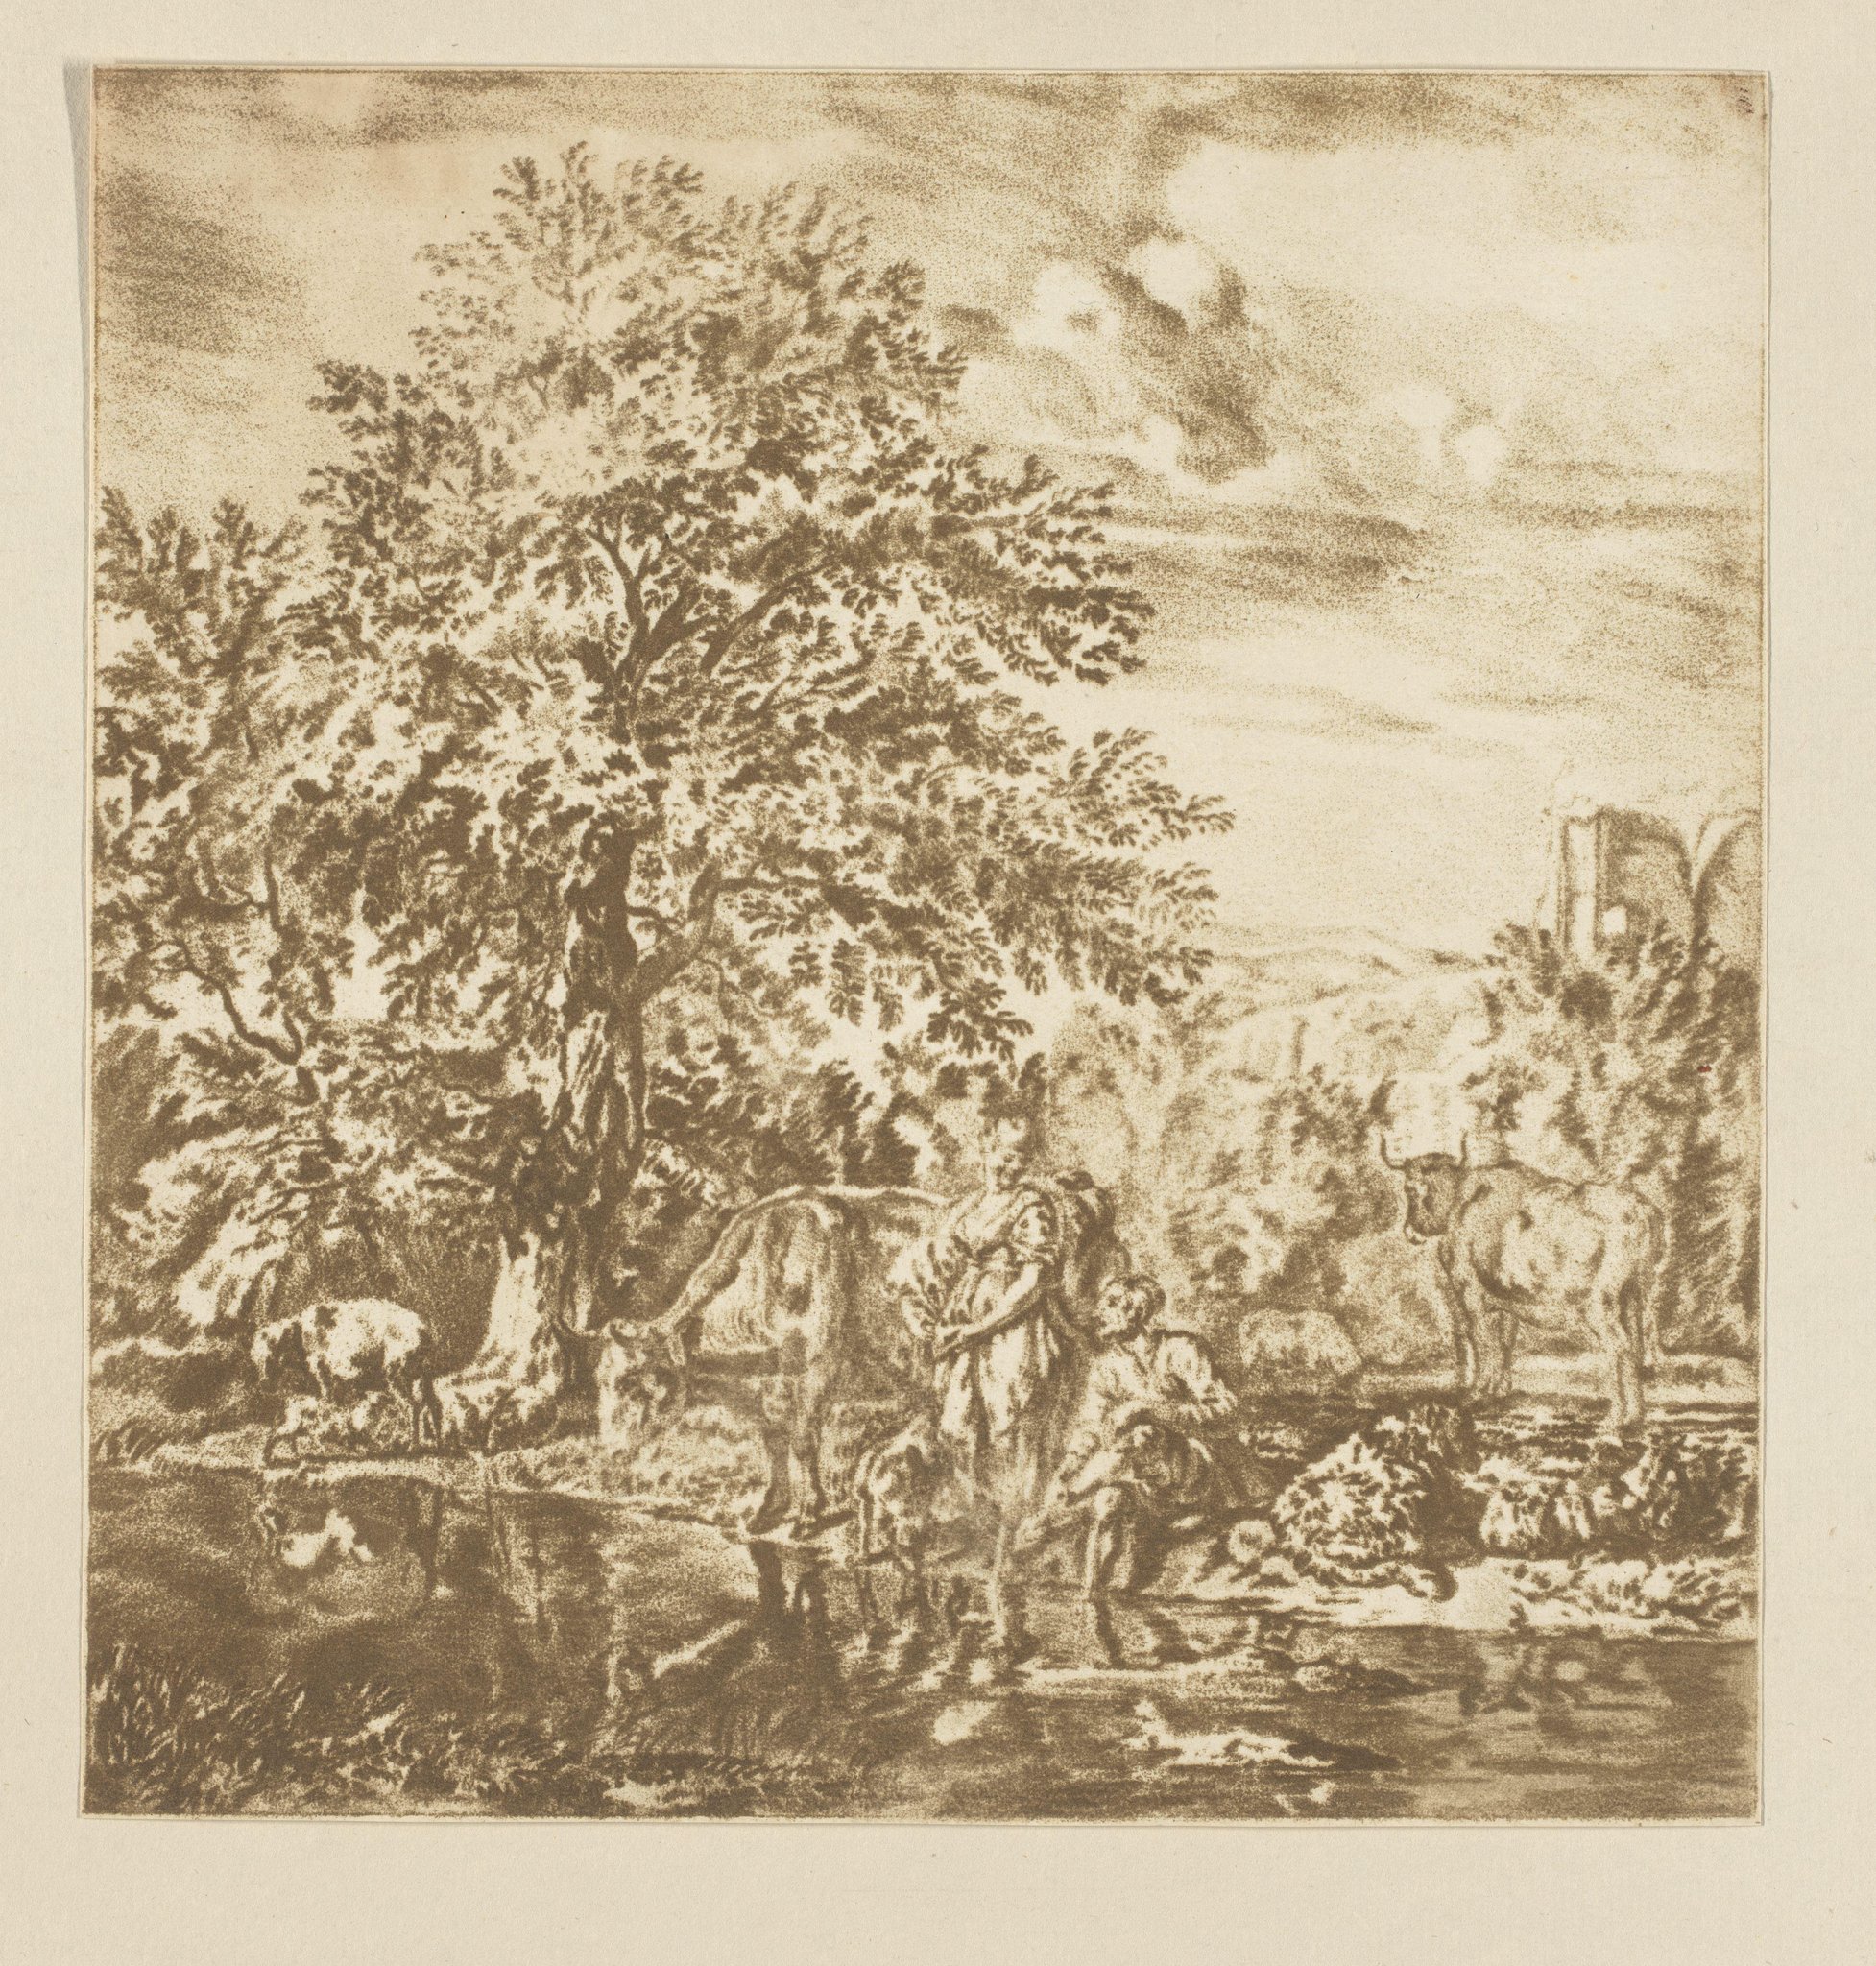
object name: print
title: Herder en herderin met kudde bij een rivier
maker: cornelis ploos van amstel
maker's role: draughtsman, print maker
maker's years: 1726-1798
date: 1763-1765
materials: paper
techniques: transfer, print drawing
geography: amsterdam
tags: cow, herding, herdsman, herdswoman, shepherd, shepherdess, cowherd, etc., sheep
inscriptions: collector's mark: ‘RIJKS / MUSM’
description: Een herder en een herderin staan op de oever van een rivier met hun schapen en koeien. De prent ligt los in een album, zie blad 4.